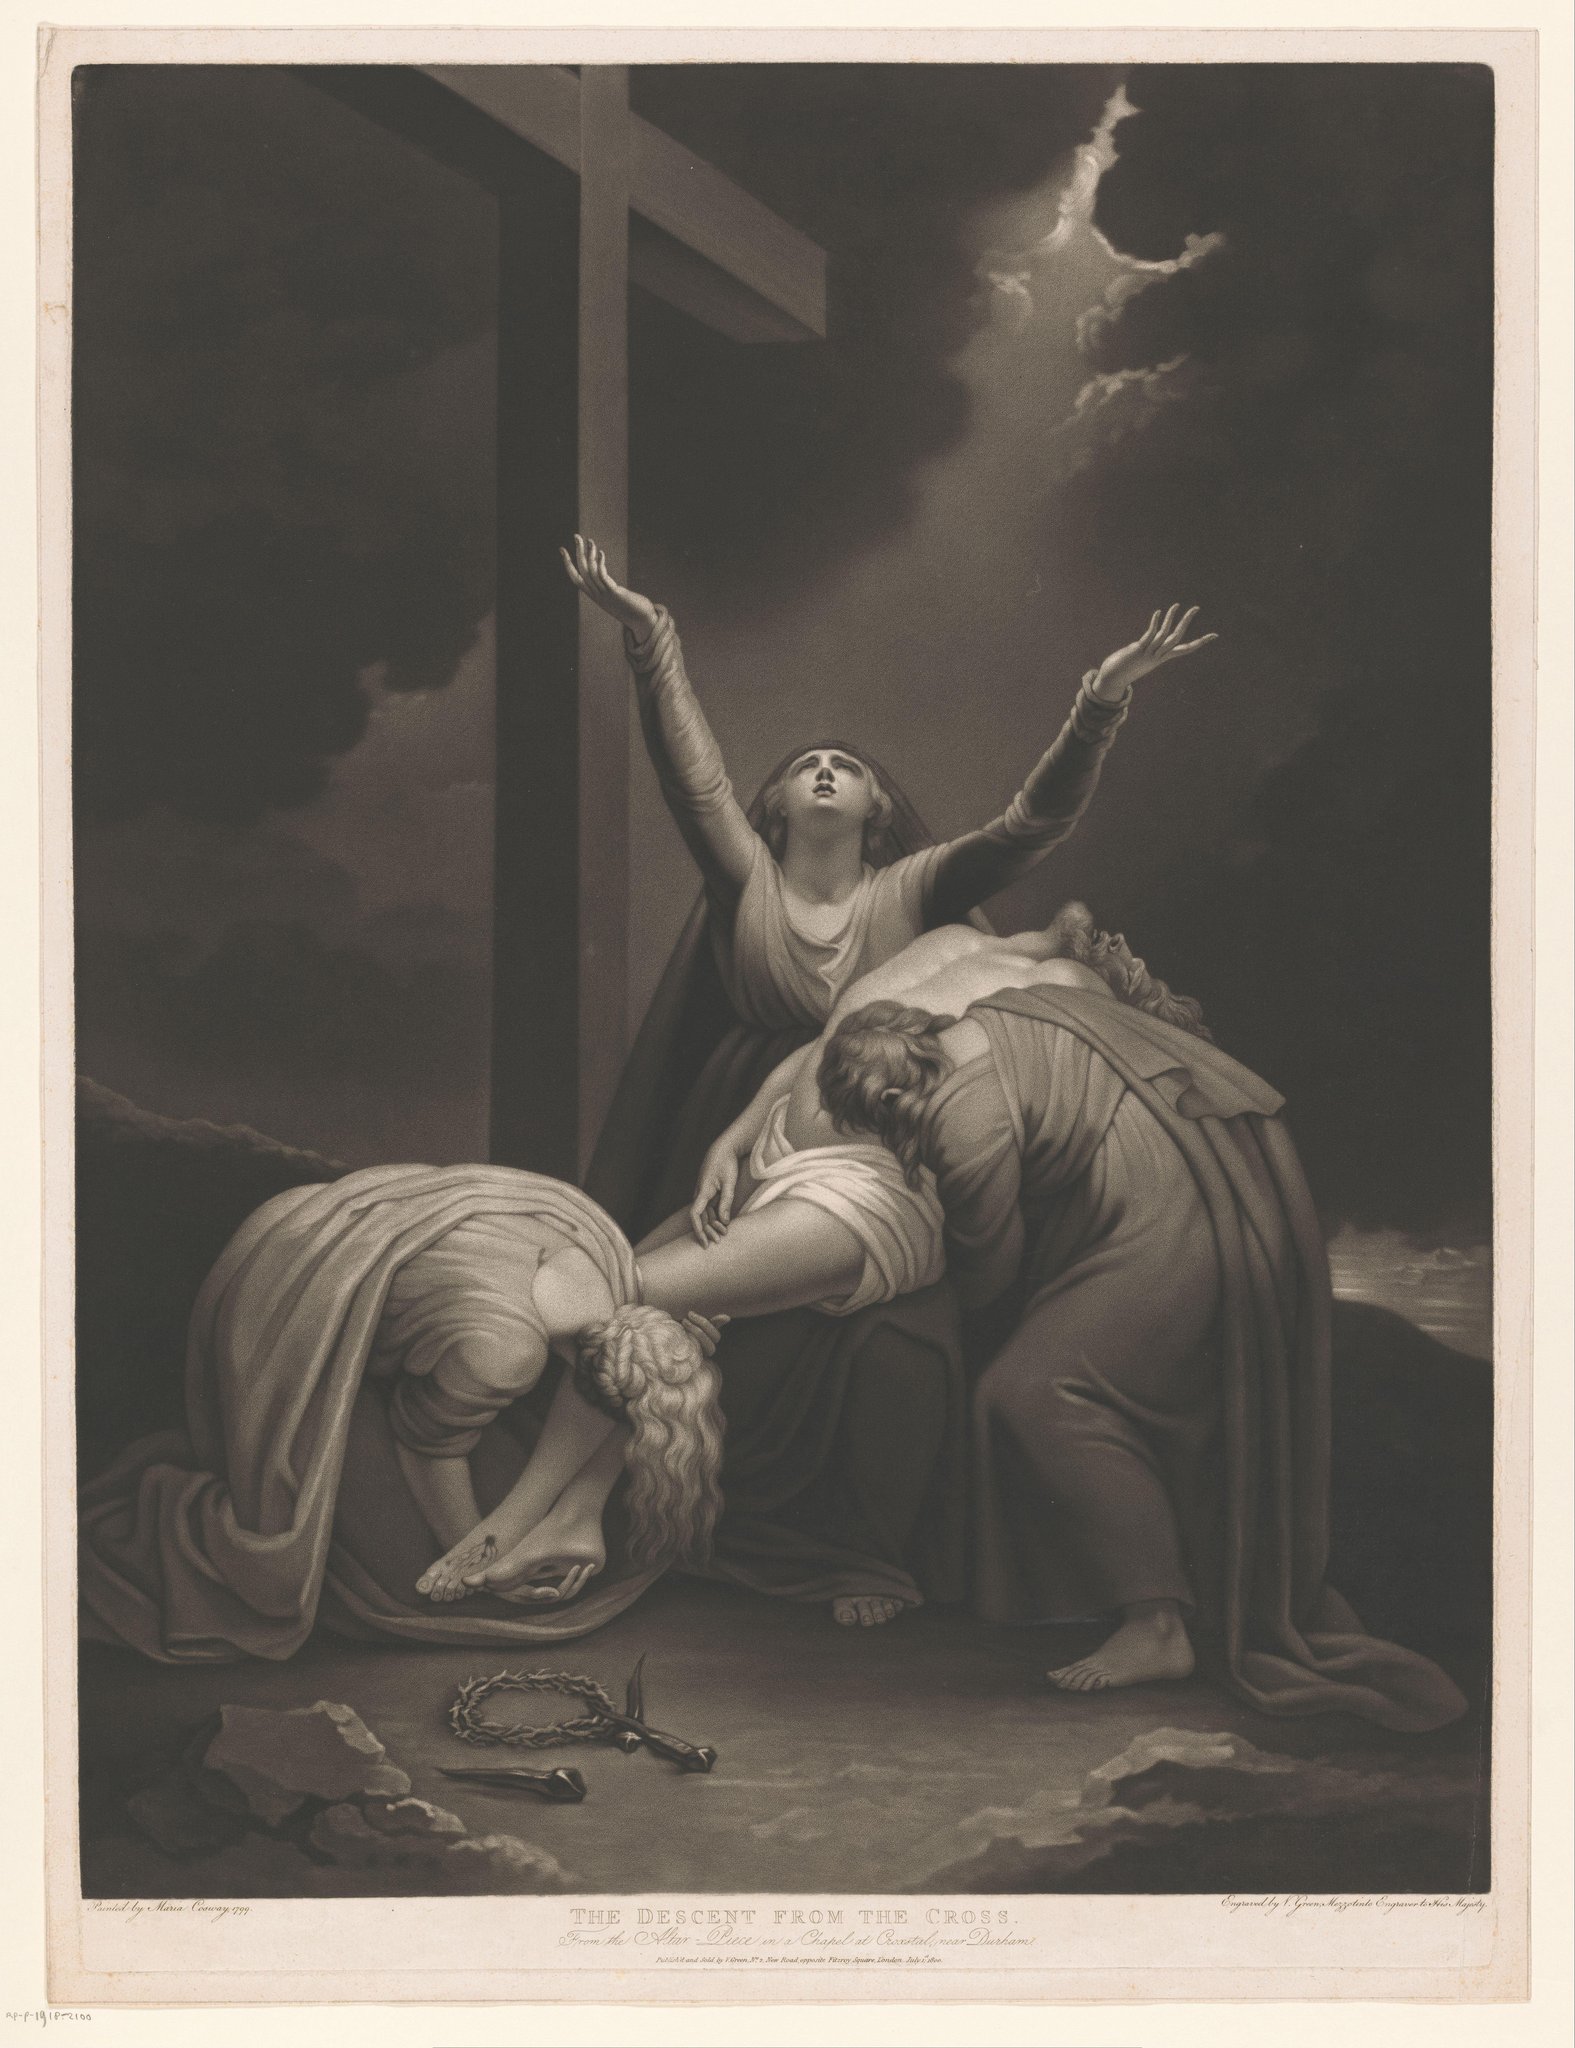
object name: print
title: The Descent from the Cross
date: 1800-1807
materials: paper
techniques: mezzotint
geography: london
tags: descent from the cross: christ is taken down from the cross, usually by nicodemus and joseph of arimathaea who are standing on the ladders (both arms of christ detached)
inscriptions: collector's mark: Lugt 2233